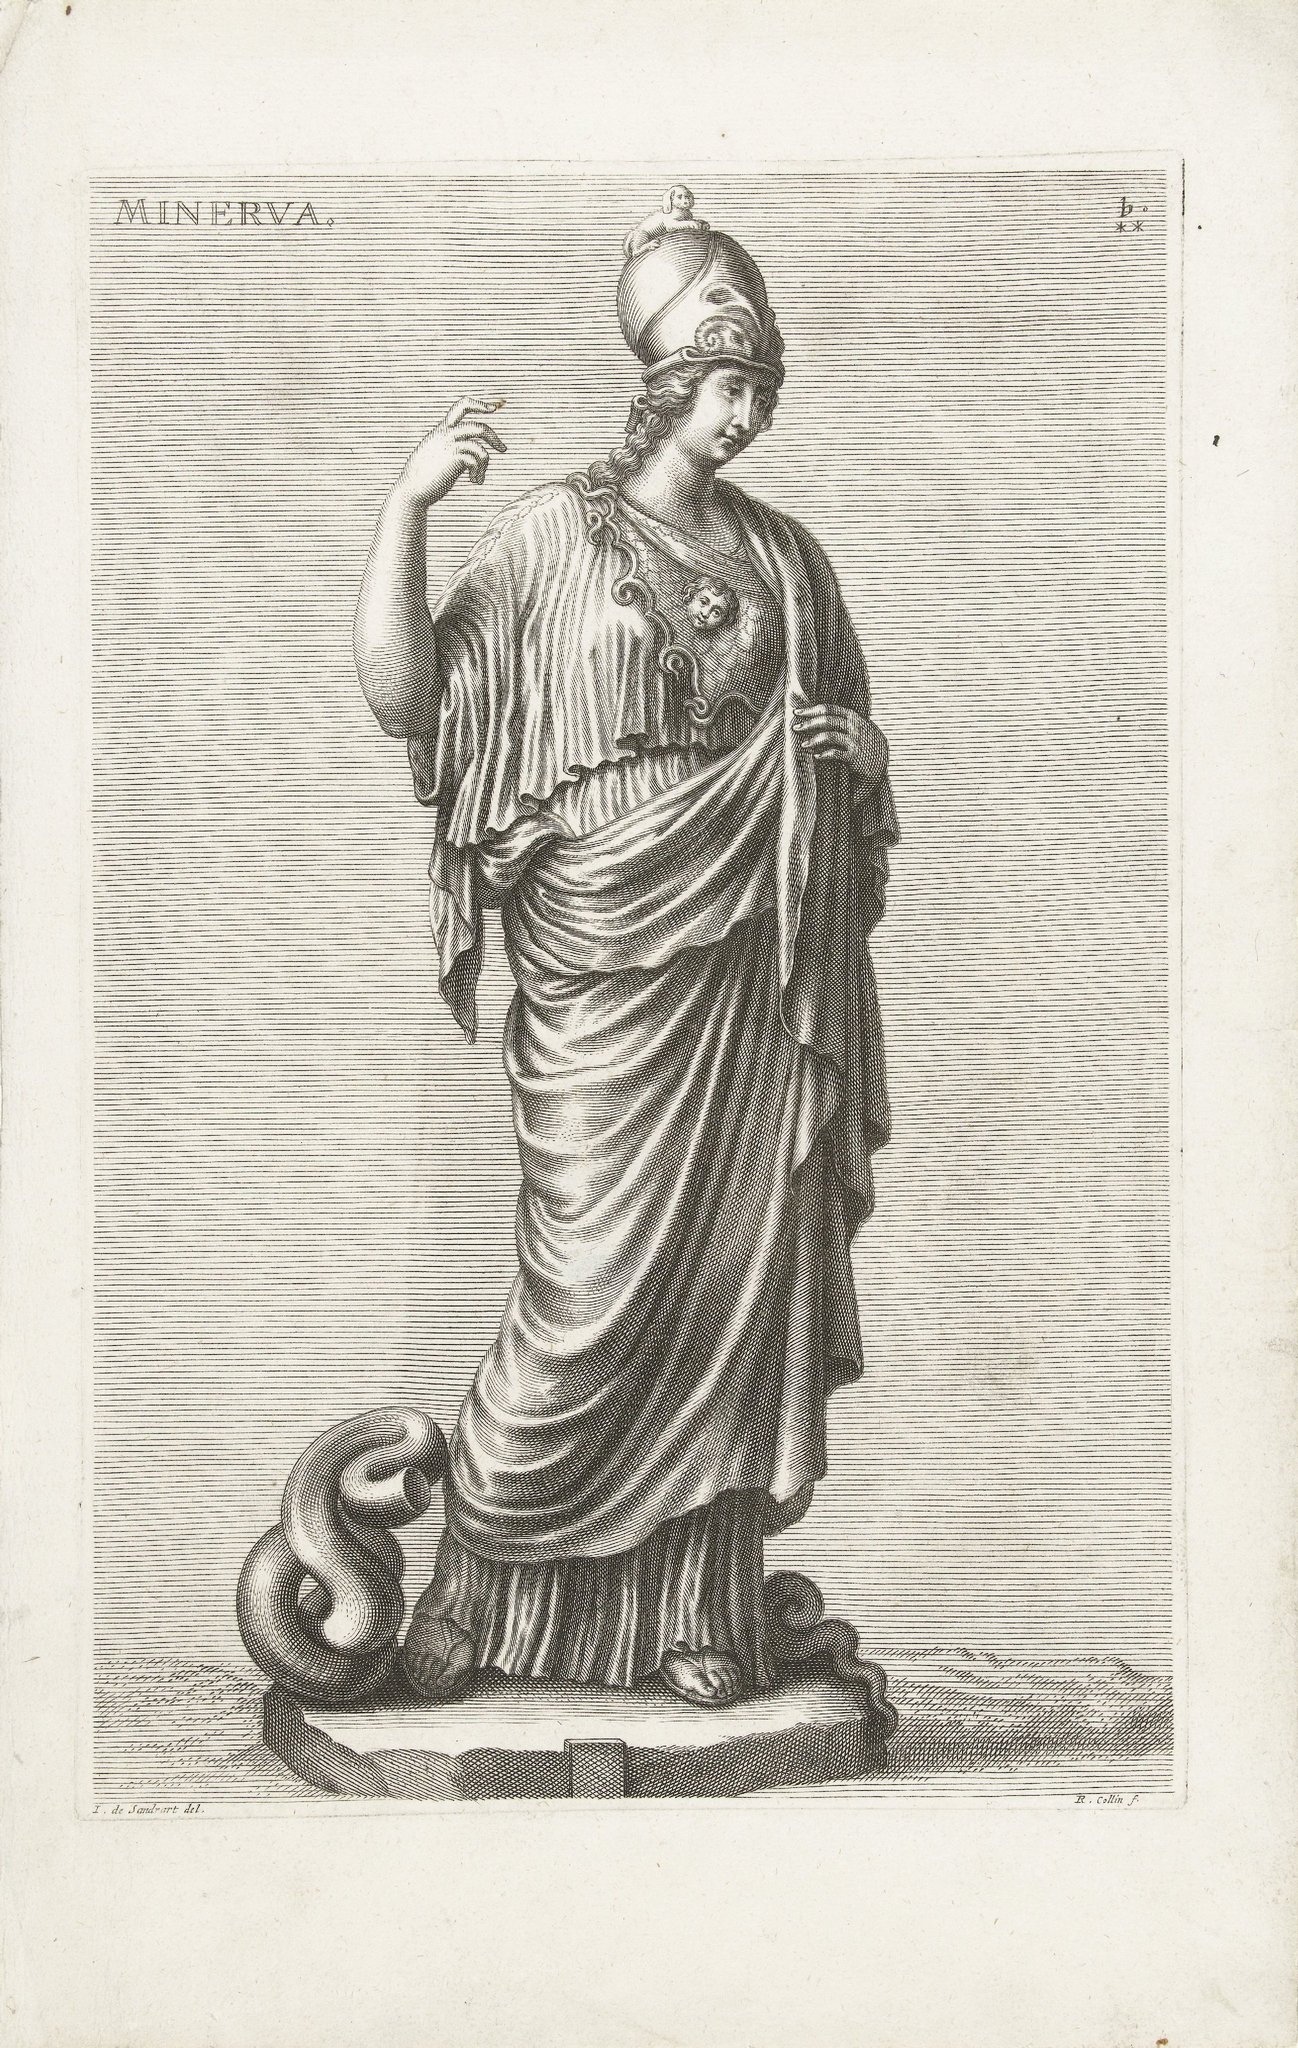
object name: book illustration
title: Minerva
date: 1675-1680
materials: paper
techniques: engraving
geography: antwerp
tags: (story of) minerva (pallas, athena), piece of sculpture, reproduction of a piece of sculpture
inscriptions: collector's mark: Lugt 2228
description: Illustratie voor: Joachim von Sandrart, L'Academia Todesca della Architectura Scultura e Pittura oder Teutsche Academie der Edlen Bau-, Bild- und Mahlerey-Künste. Nürnberg: 1675-1680.